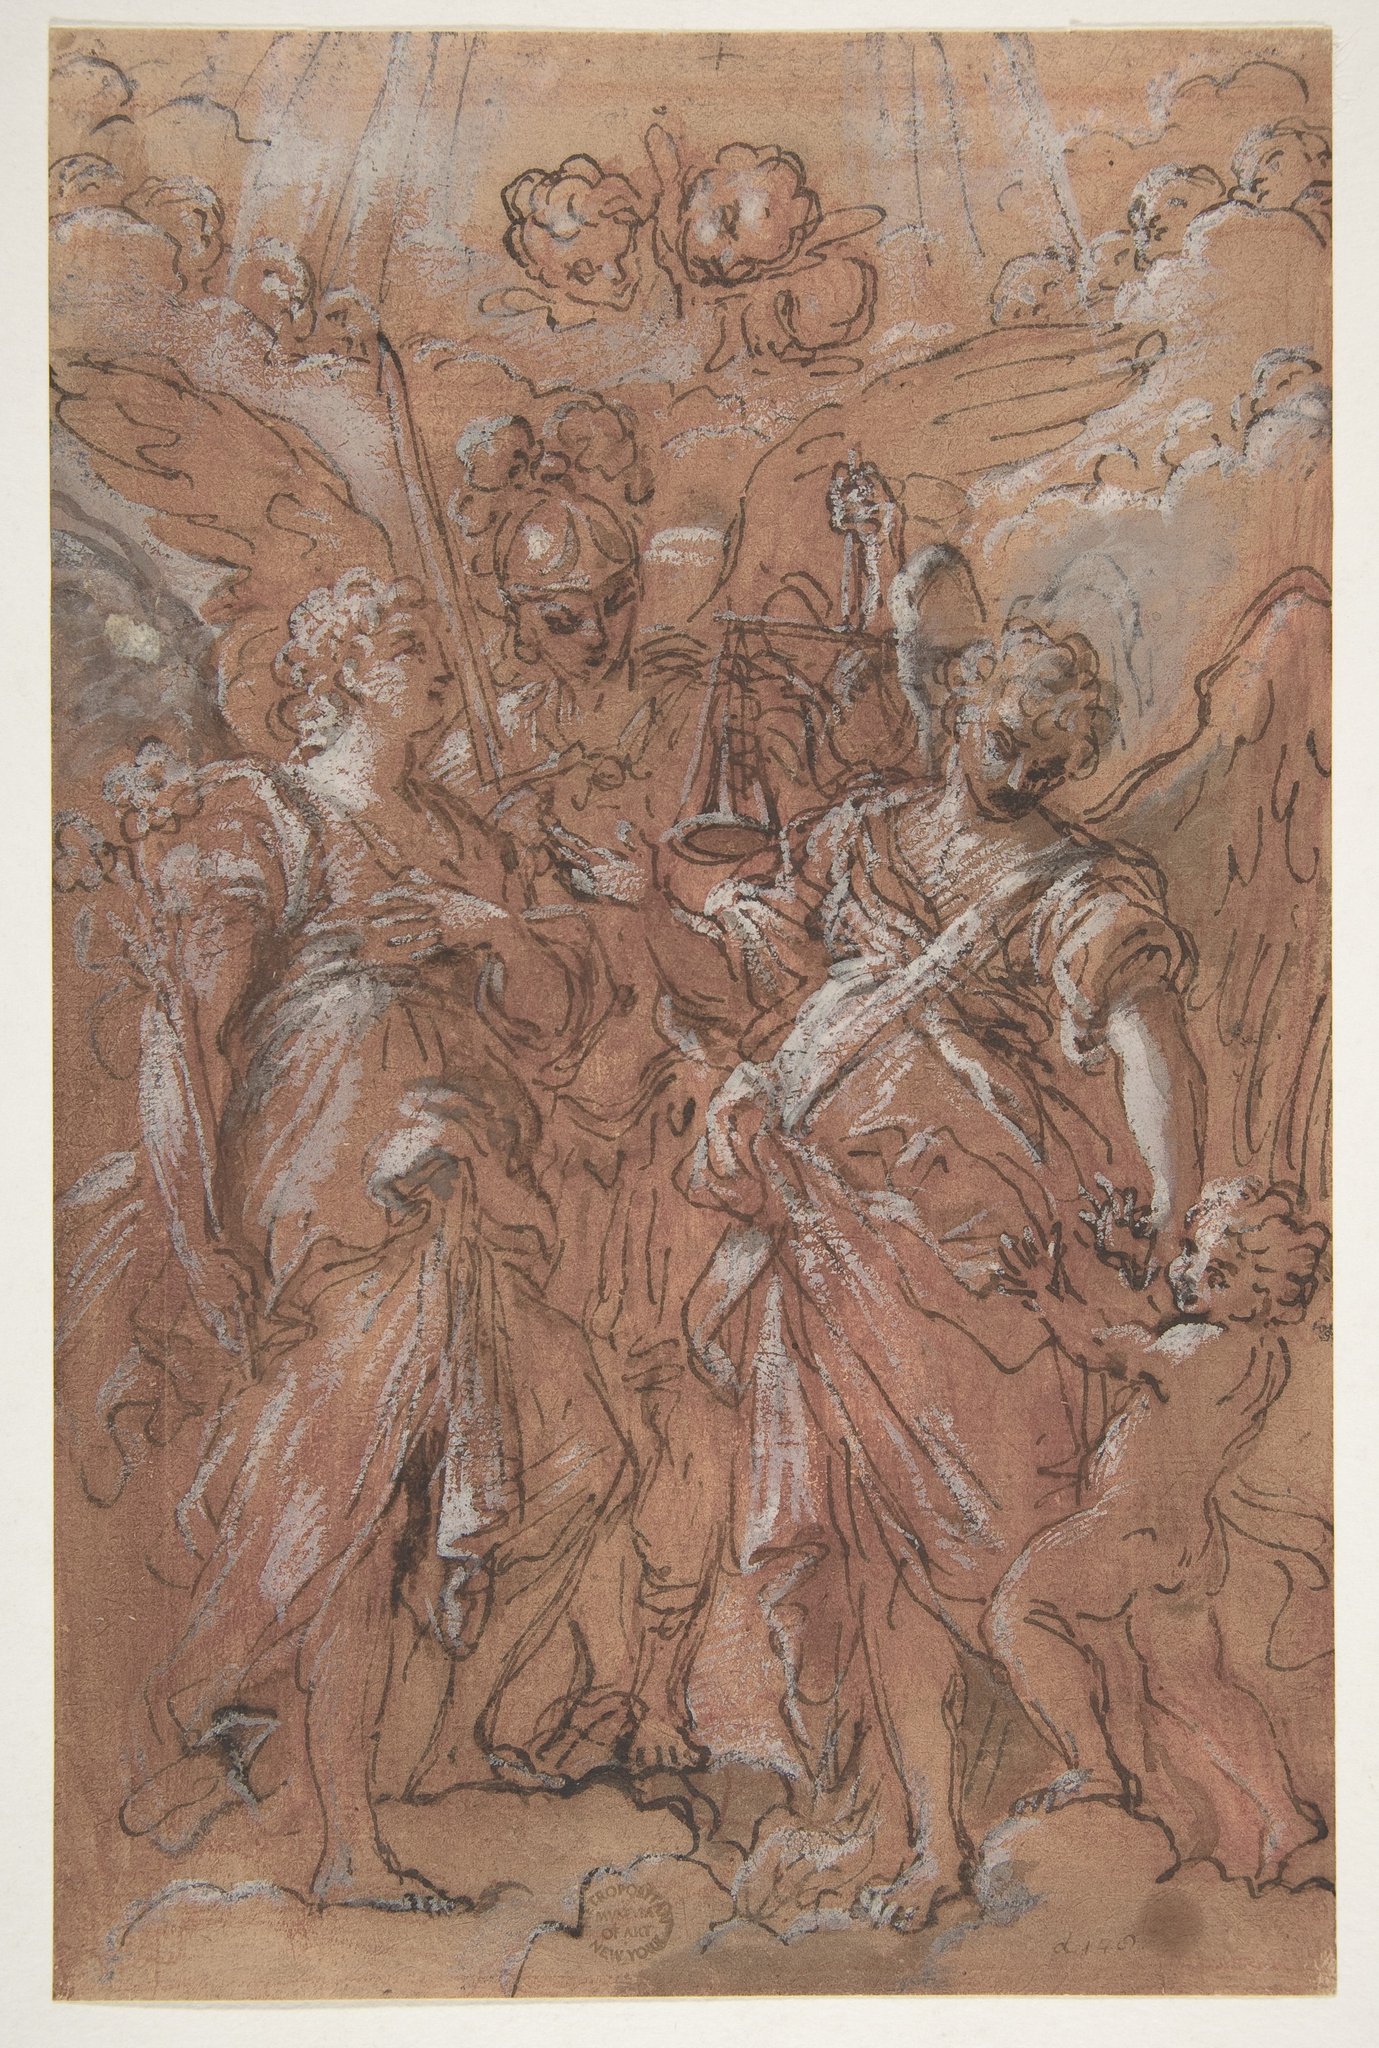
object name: drawing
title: The Archangels Gabriel, Michael and Raphael (recto); sketches of figures (verso)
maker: giuseppe passeri (passari)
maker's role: artist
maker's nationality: italian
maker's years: 1654-1714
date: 1654-1714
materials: chalk, ink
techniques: brush, highlighting, pen, wash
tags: children,angels,archangel gabriel